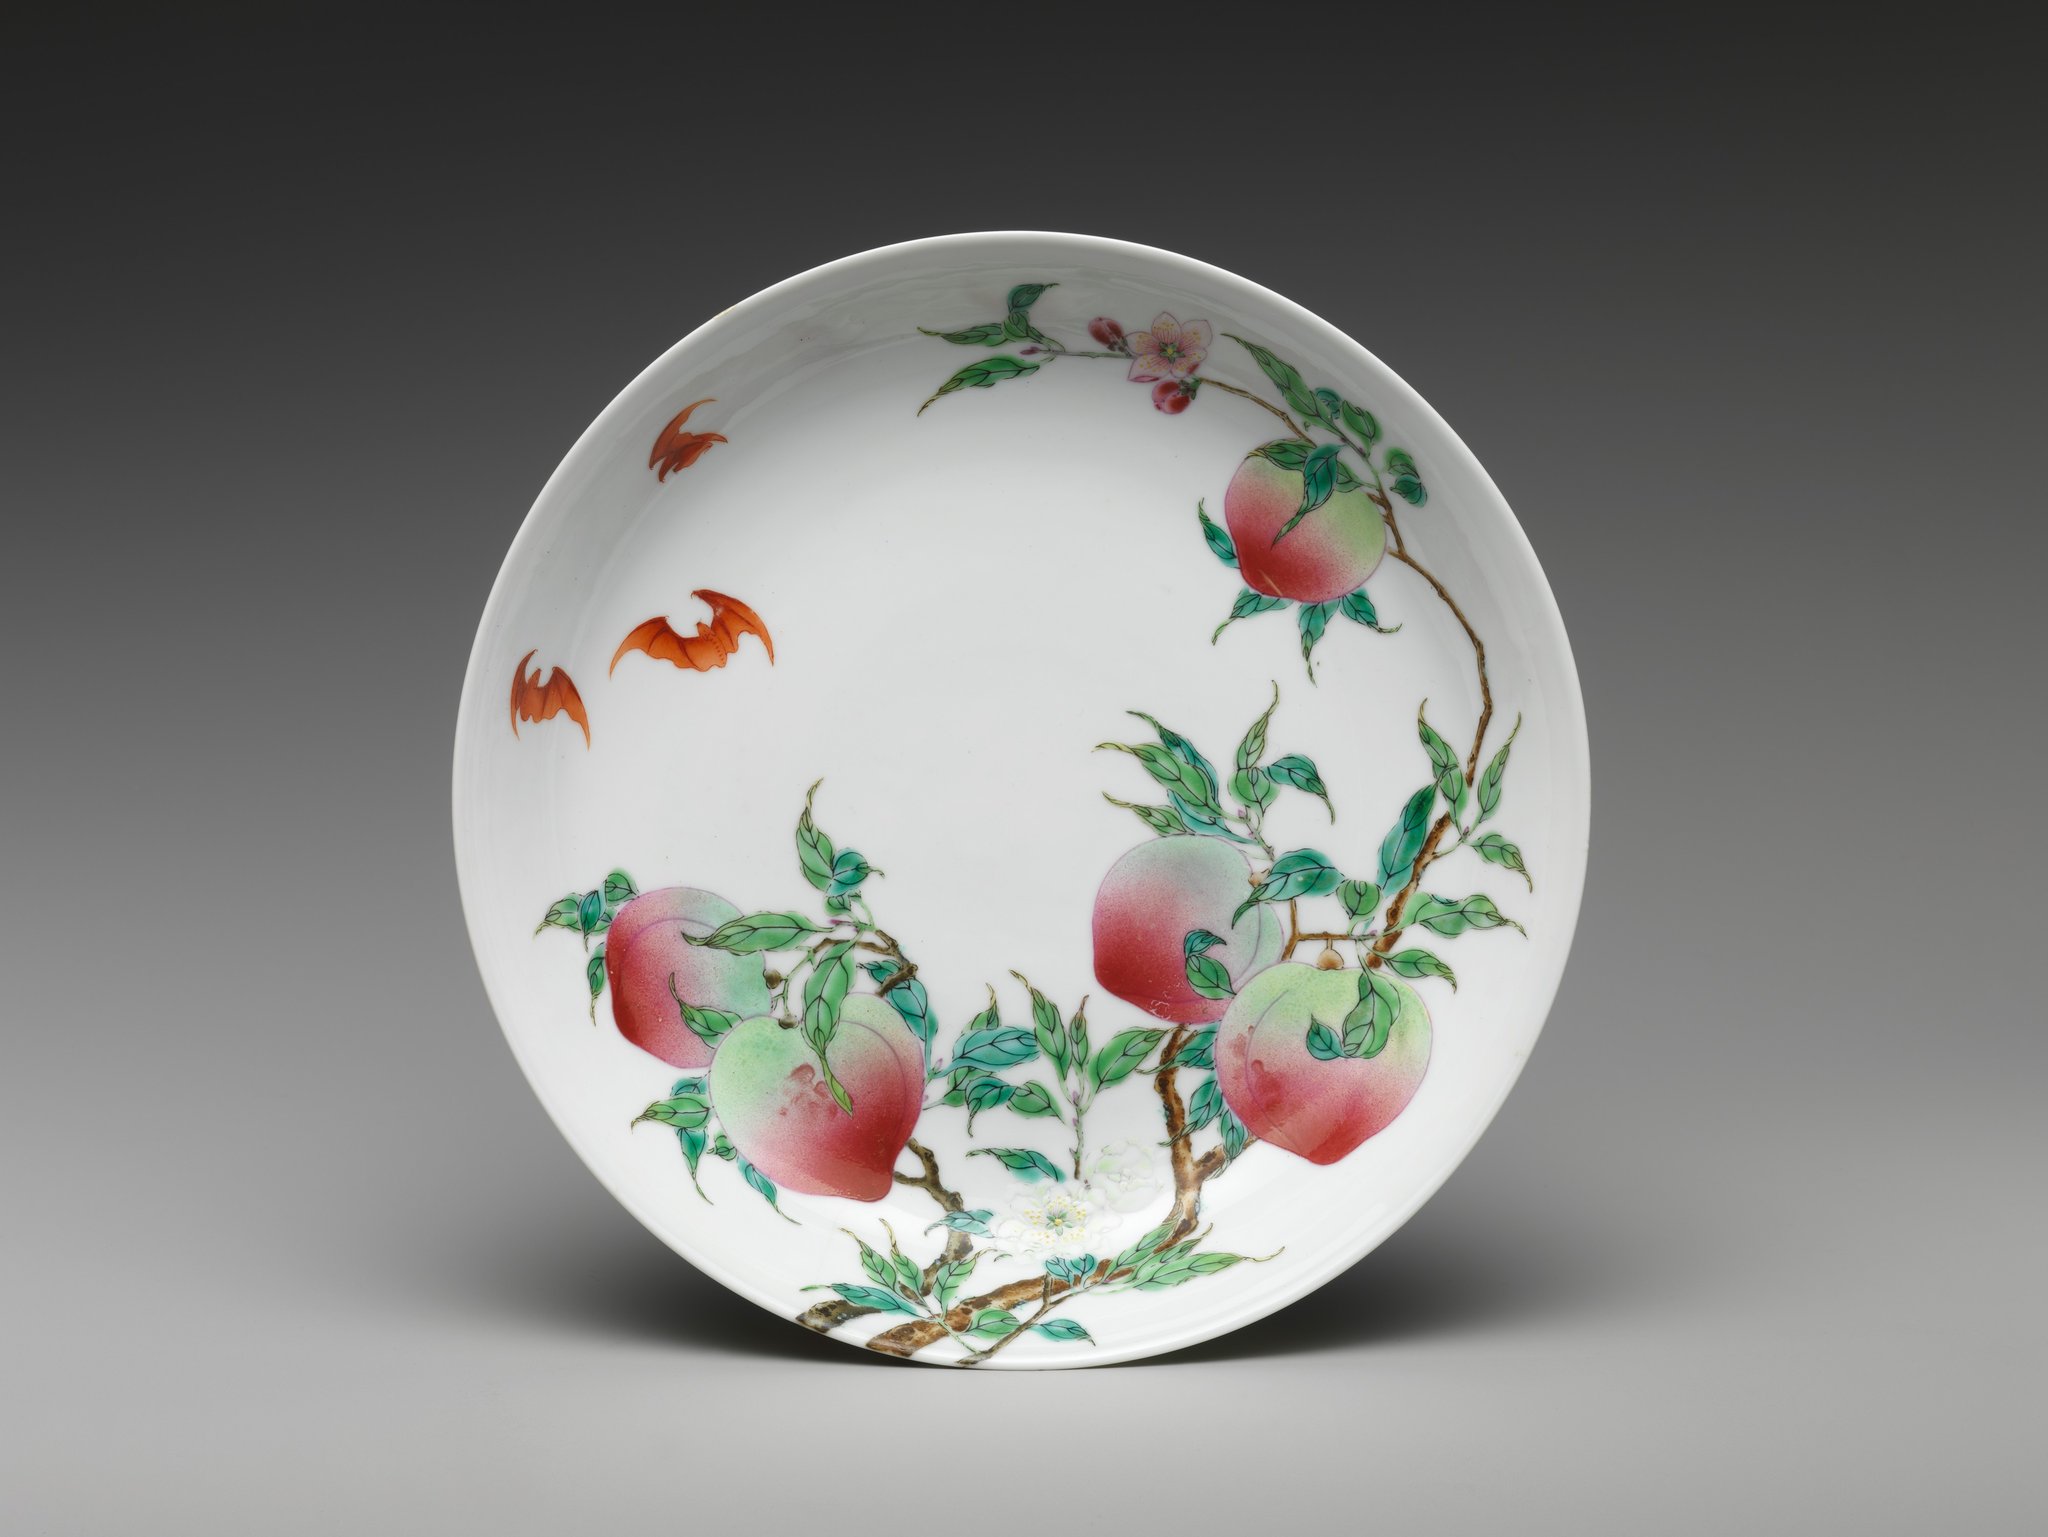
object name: dish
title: Dish with peaches and bats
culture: chinese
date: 1701-1733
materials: enamel, porcelain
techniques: overglaze, painting, polychrome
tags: bats,peaches